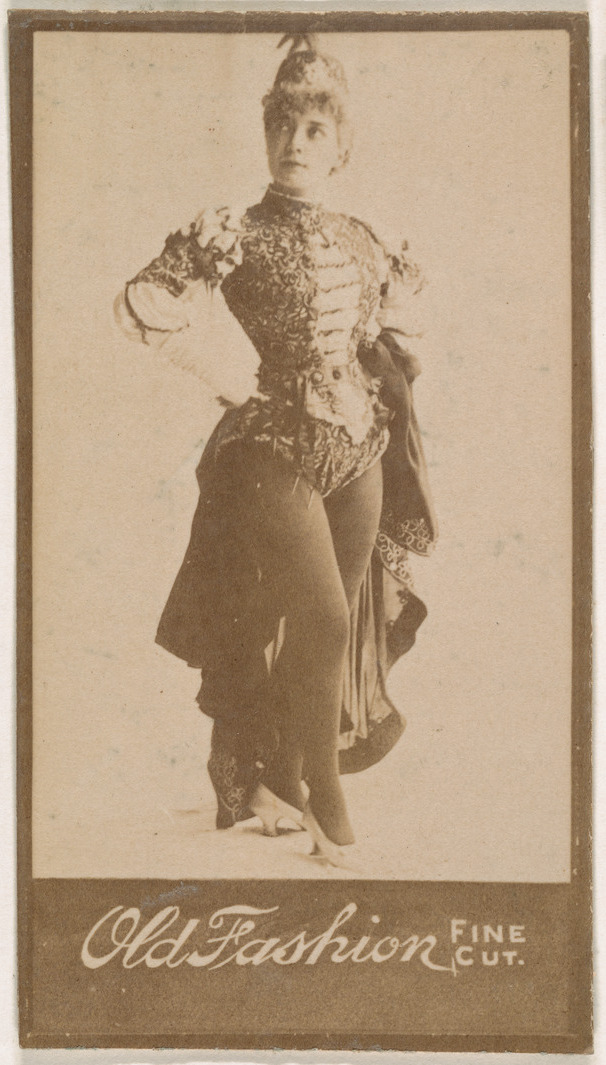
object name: photograph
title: Actress standing with hands on hips, from the Actresses series (N664) promoting Old Fashion Fine Cut Tobacco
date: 1888-1890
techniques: albumen silver print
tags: portraits,women,actresses